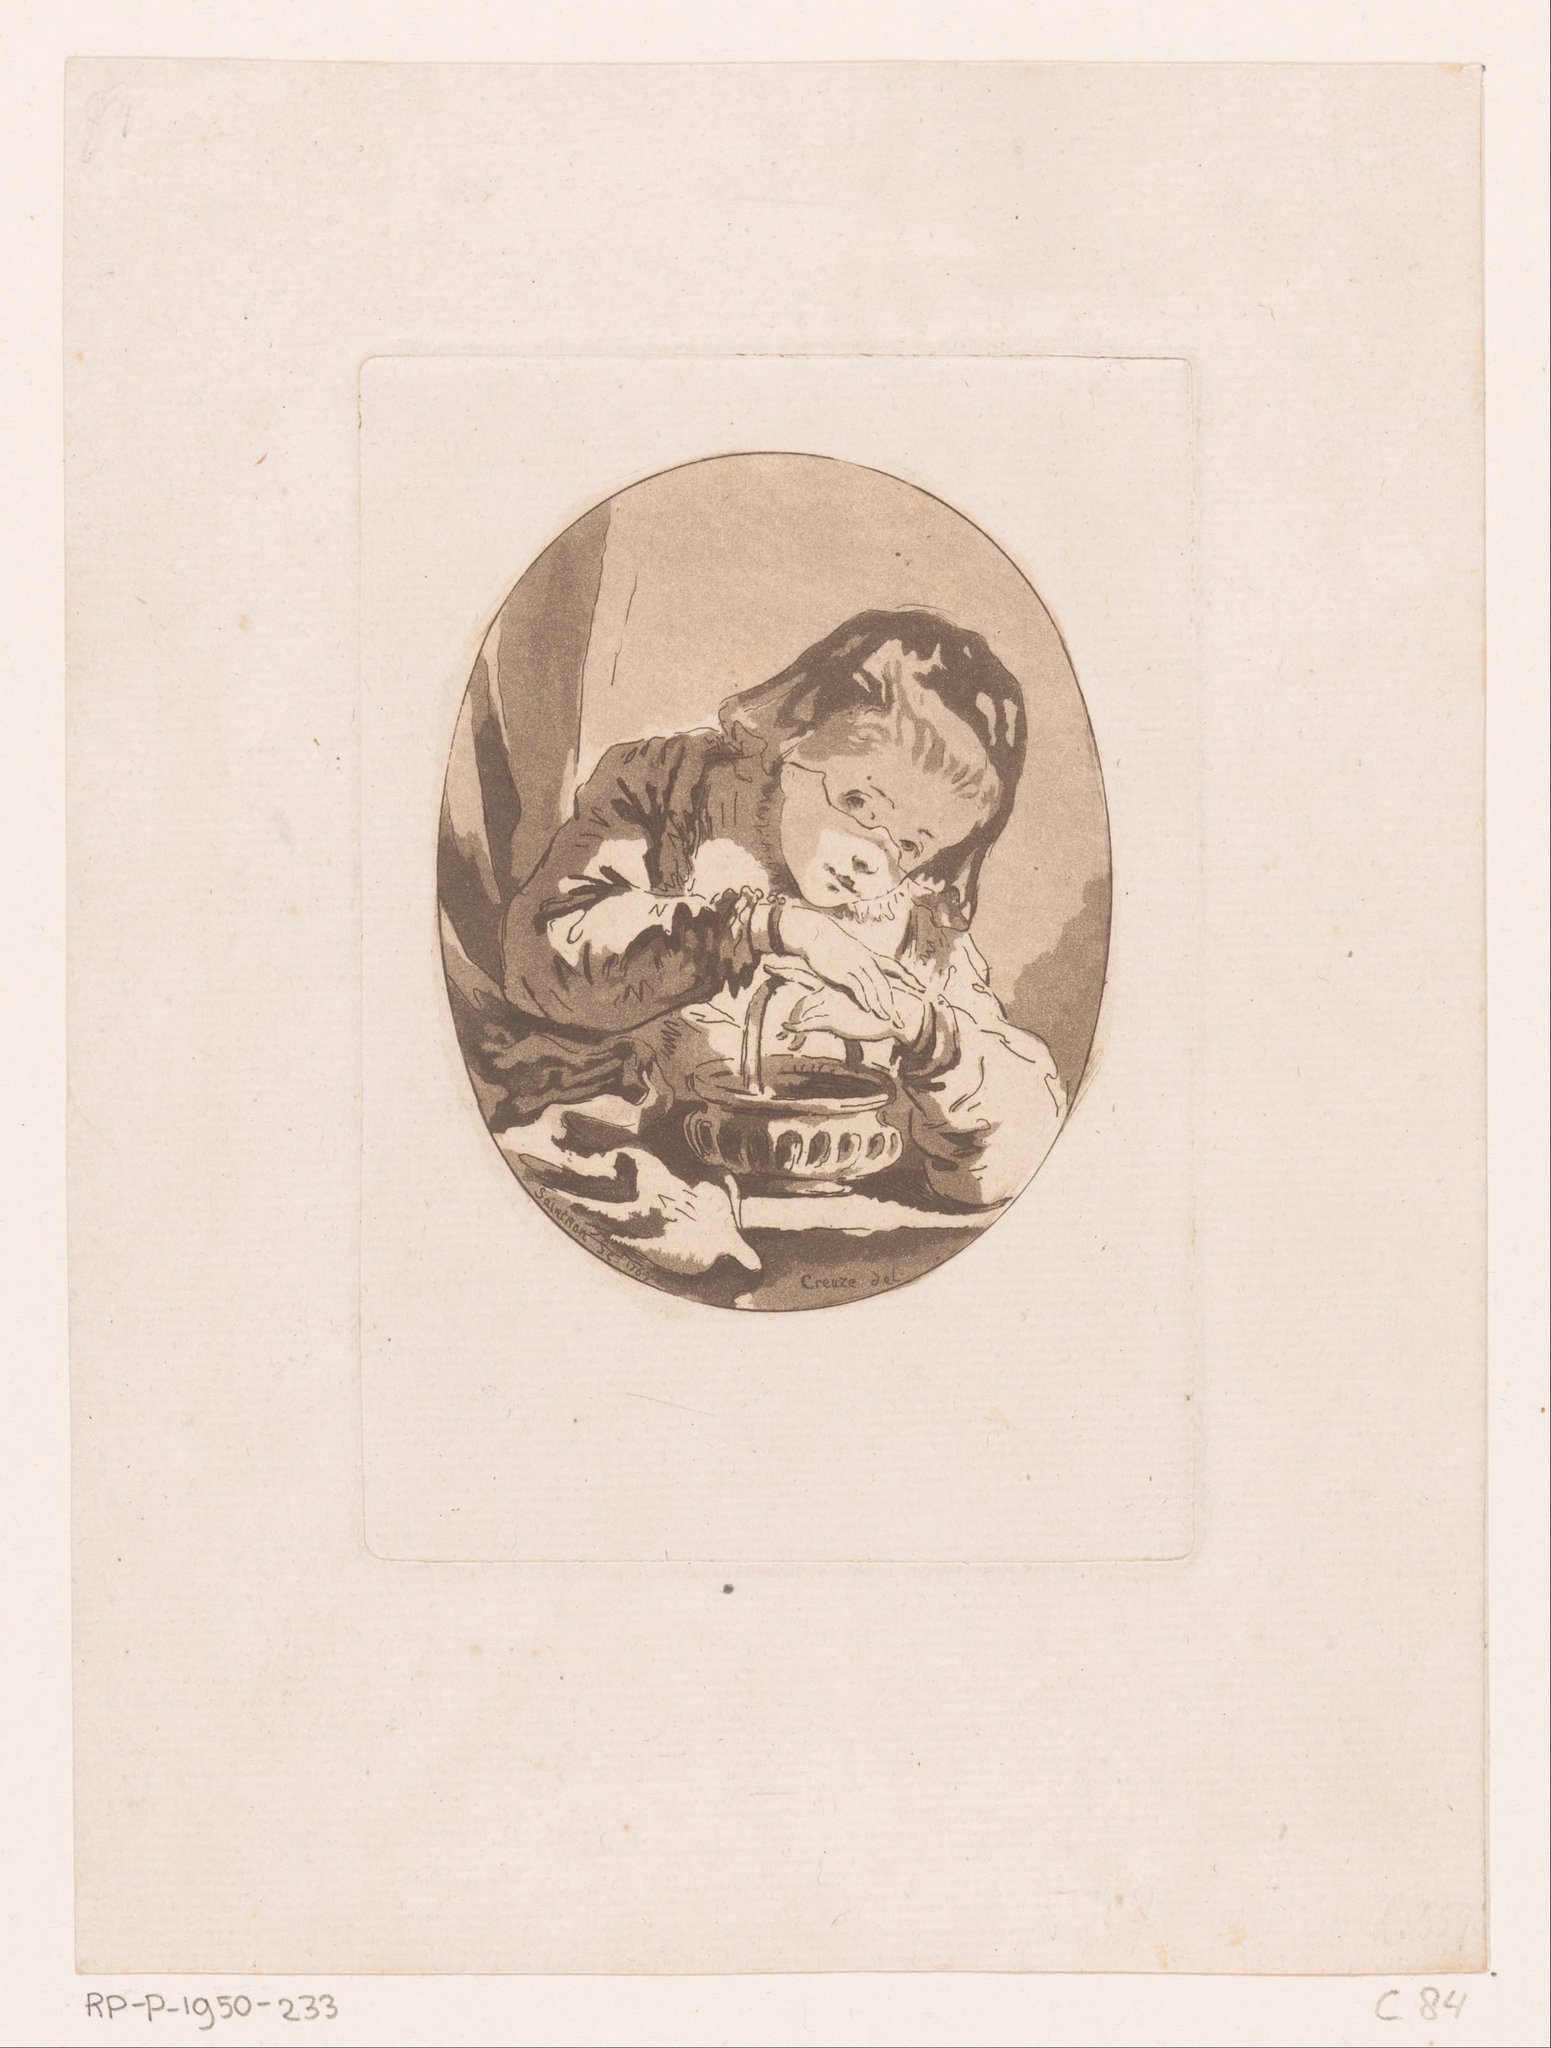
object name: print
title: Gesluierd meisje met mandje voor zich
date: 1767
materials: paper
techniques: aquatint, etching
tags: adolescent, young woman, maiden, veil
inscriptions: collector's mark: Lugt 2228